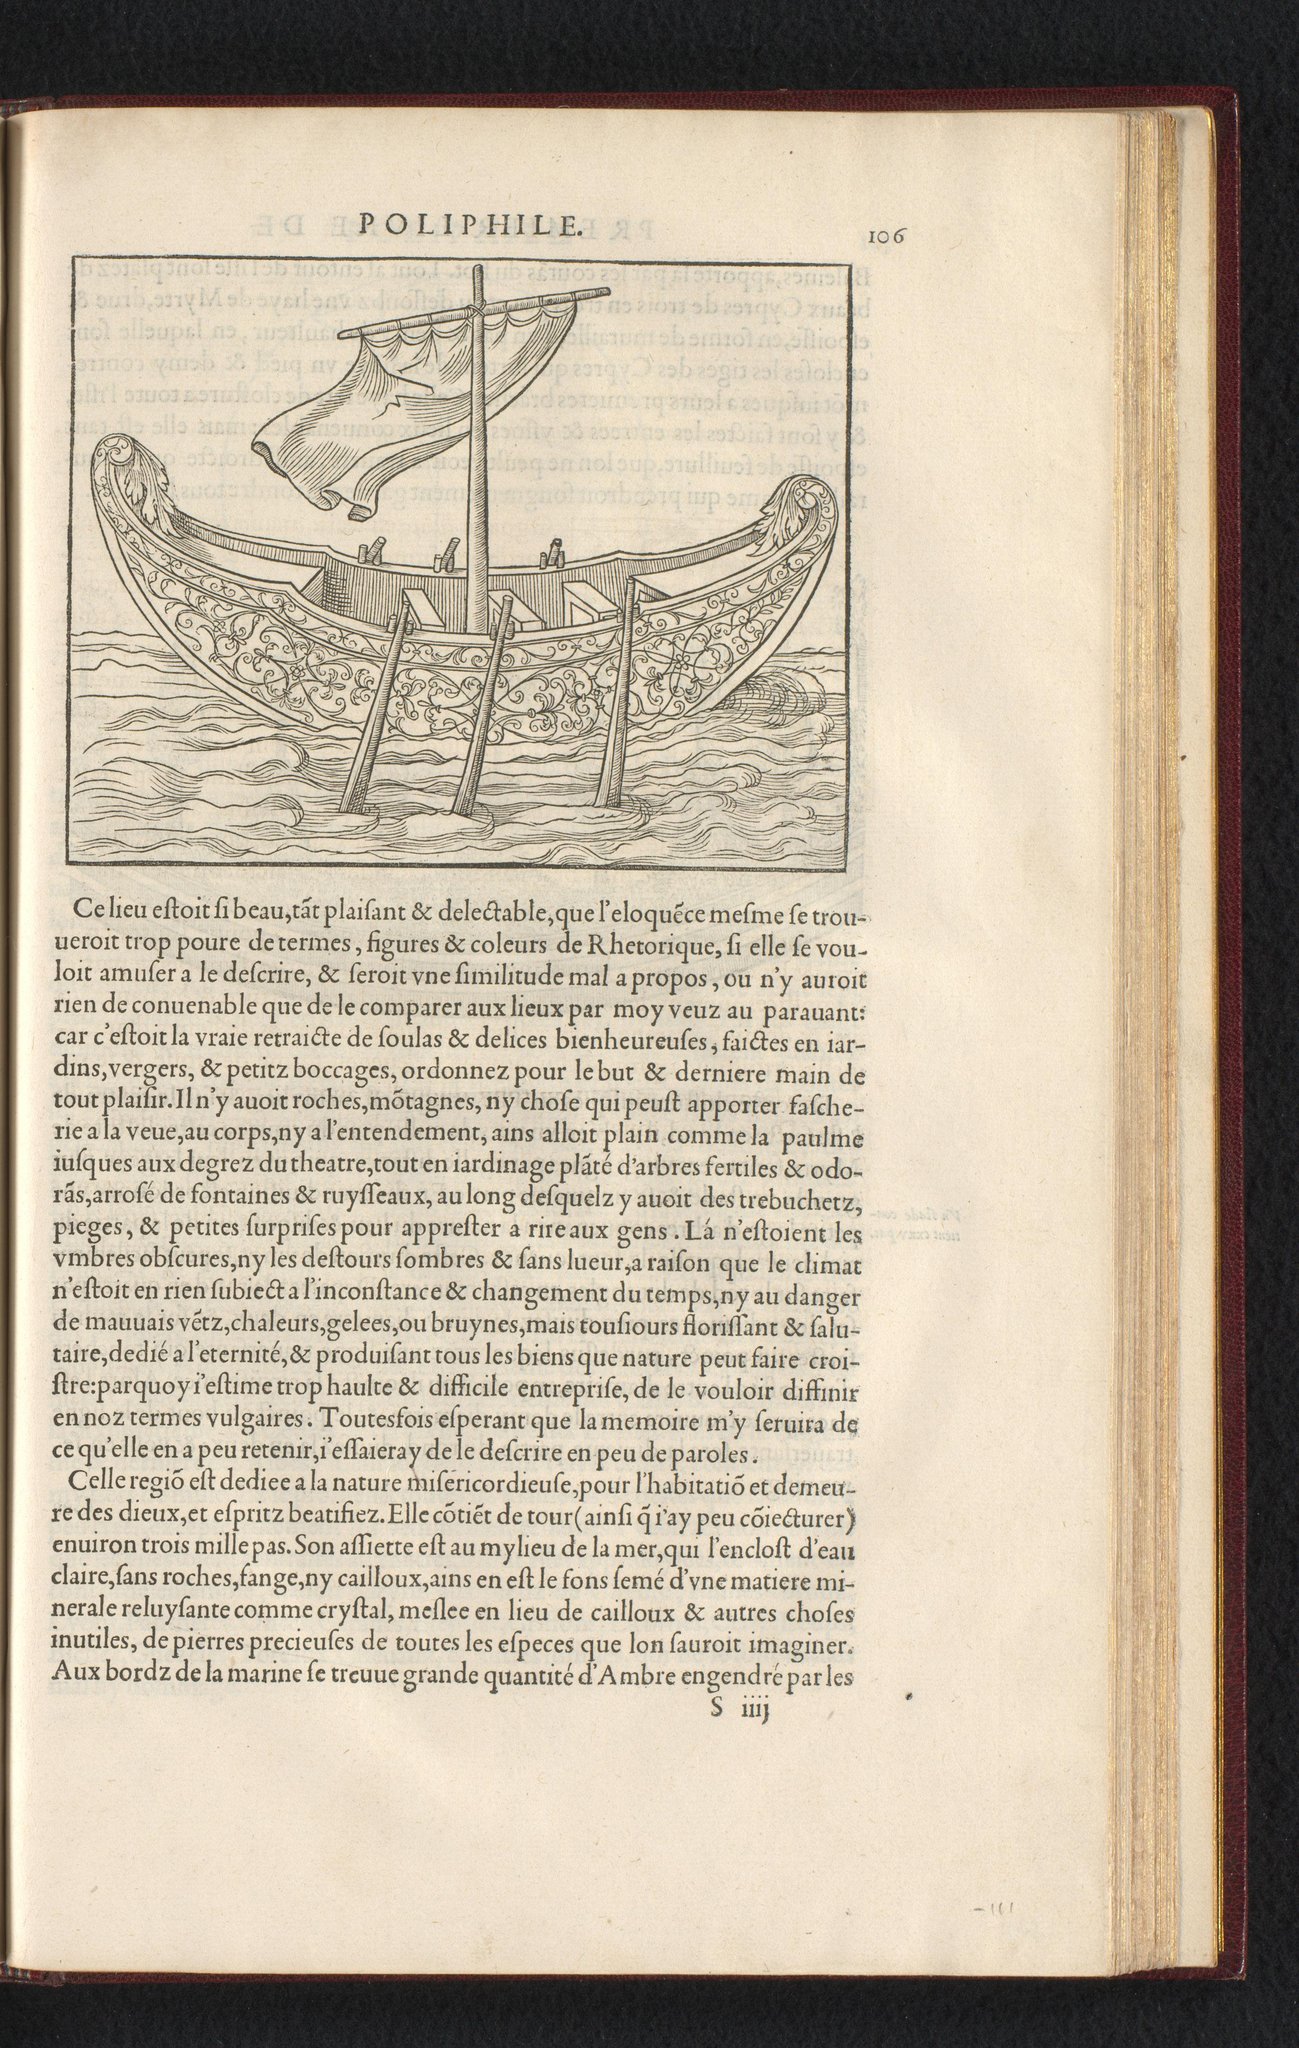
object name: book illustration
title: Roeiboot met een enkel zeil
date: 1546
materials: paper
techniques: letterpress printing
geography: paris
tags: sailing-ship, sailing-boat, (scenes from) specific works of literature: colonna, hypnerotomachia poliphili, rowing-boat, canoe, etc.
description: Prent uit: Colonna, Francesco. Hypnerotomachie ou discours du songe de Poliphile, deduisant comme amour le combat a l'occasion de Polia. Parijs: Jacques Kerver, 1546, recto fol. 106.